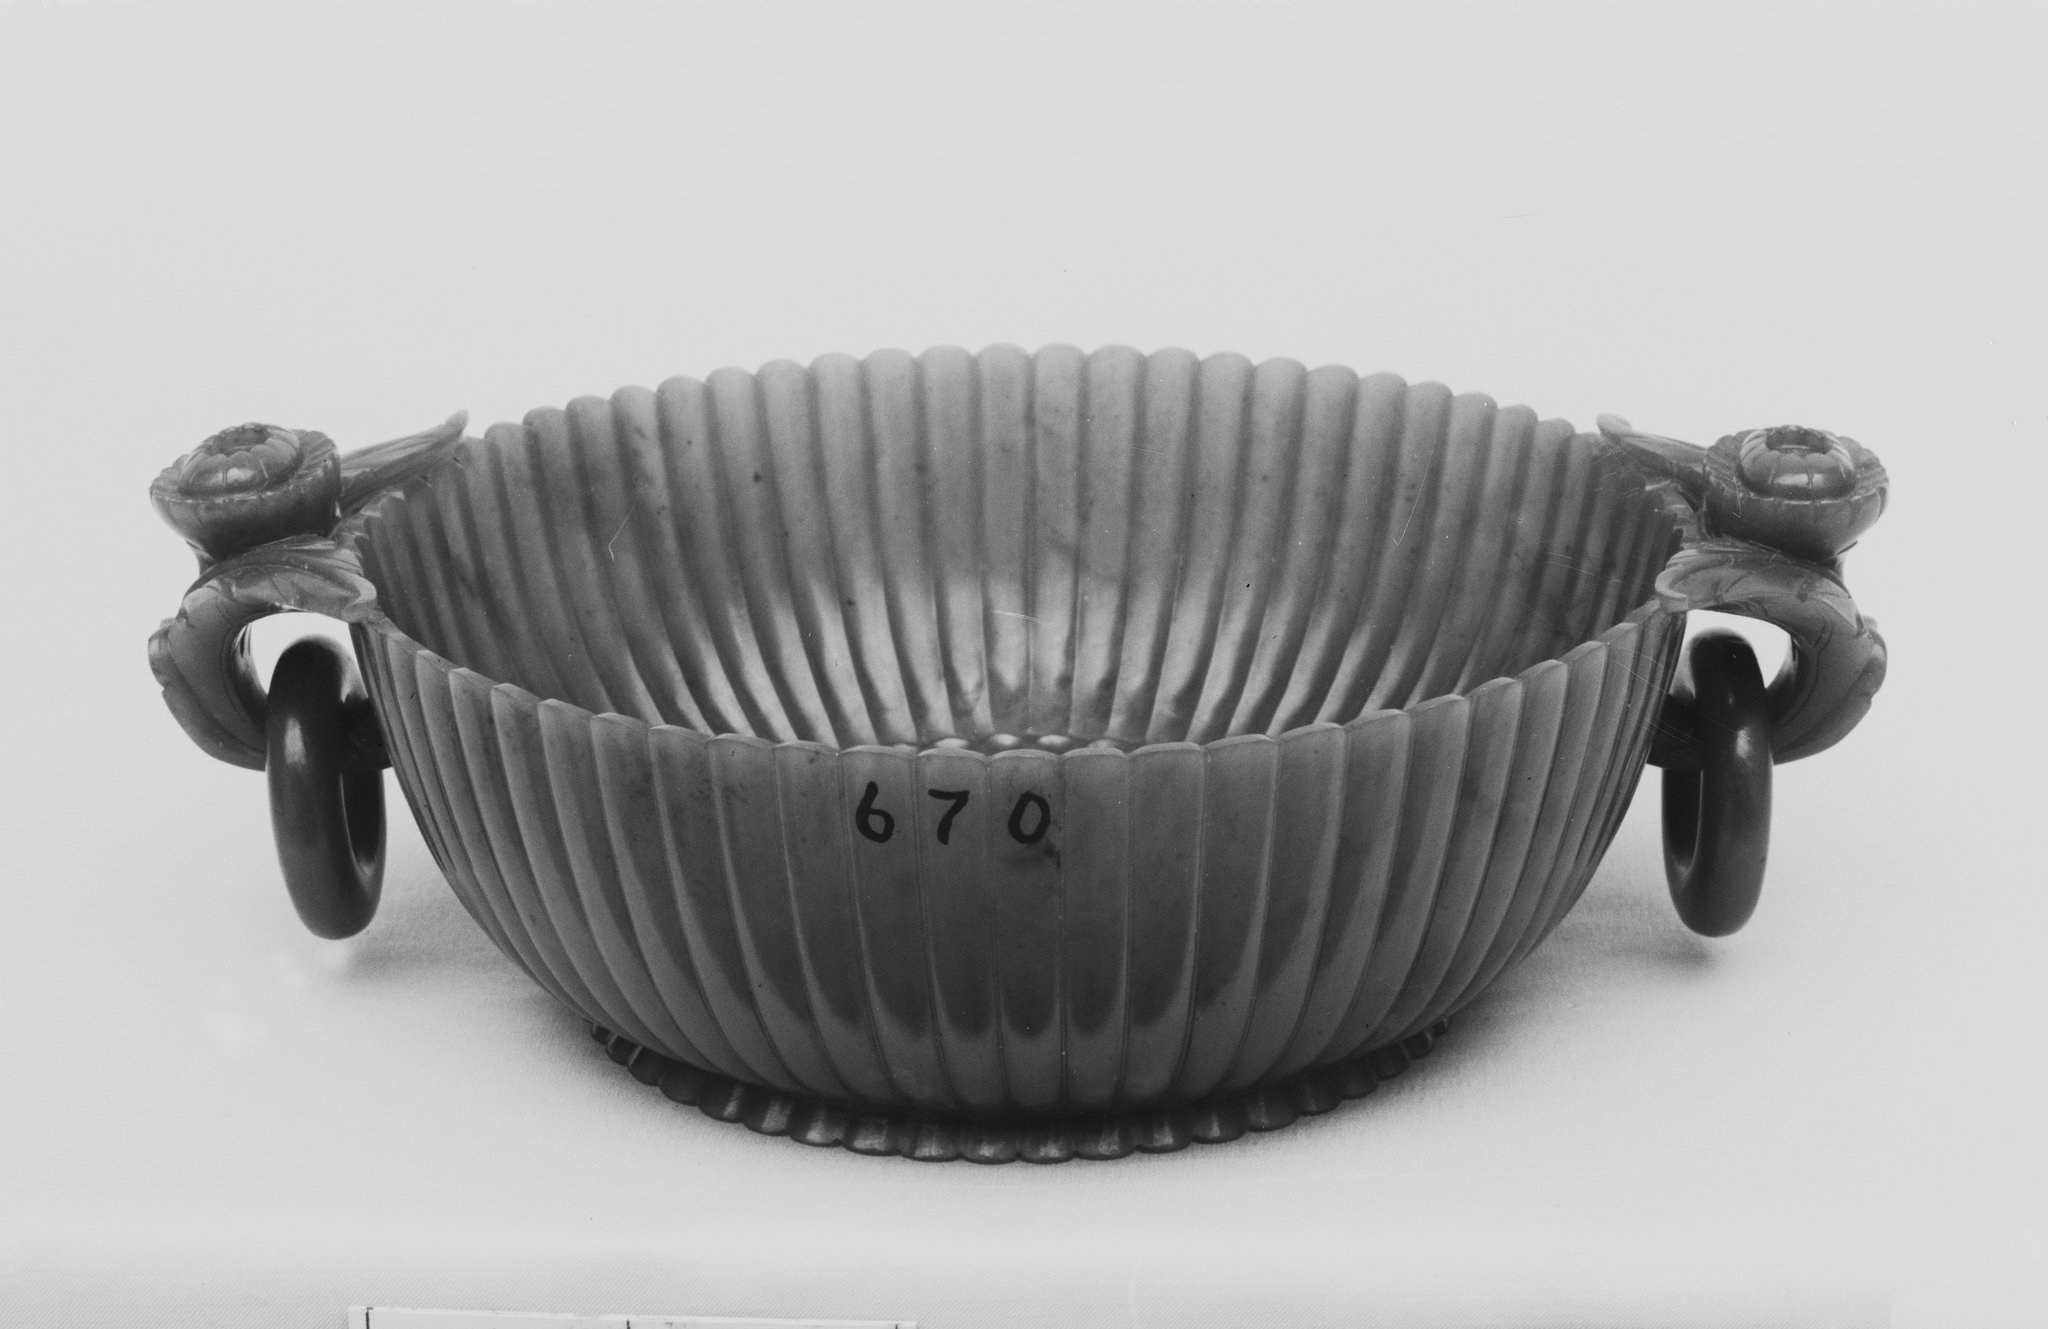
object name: bowl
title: Bowl with ring handles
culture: chinese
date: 1701-1900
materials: jade